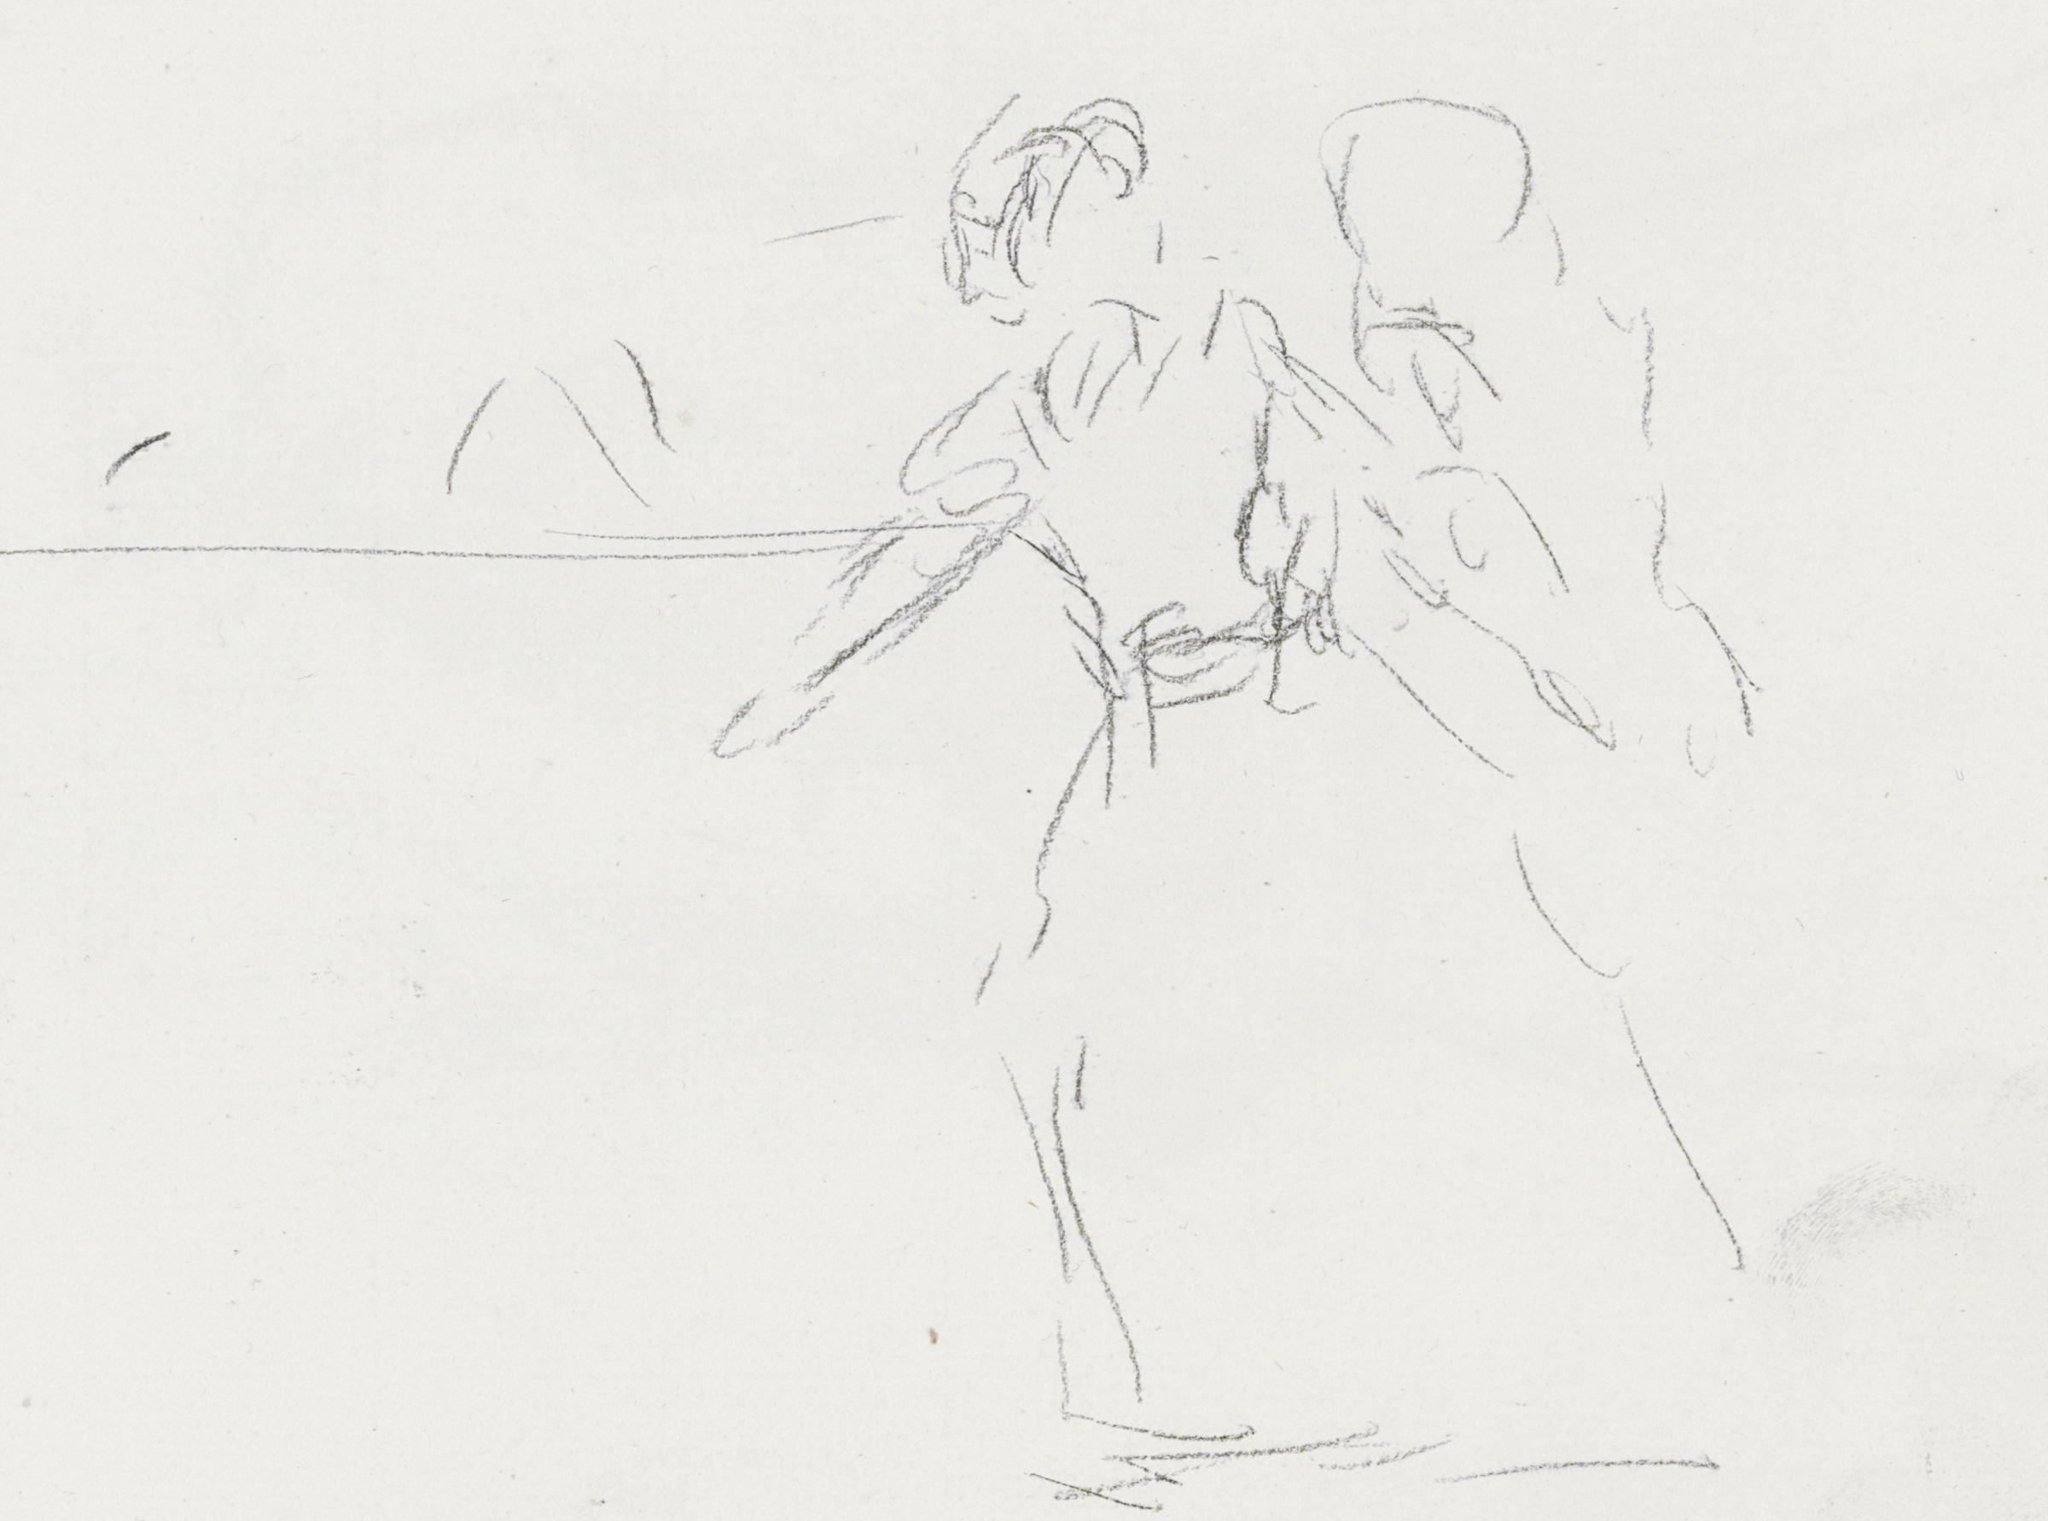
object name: sketchbook leaf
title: Figuurstudies, mogelijk twee vrouwen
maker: isaac israels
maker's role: draughtsman, painter, print maker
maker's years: 1865-1934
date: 1875-1934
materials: chalk, paper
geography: amsterdam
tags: adult woman (+ standing)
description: Blad 19 verso uit schetsboek XX met 26 bladen.